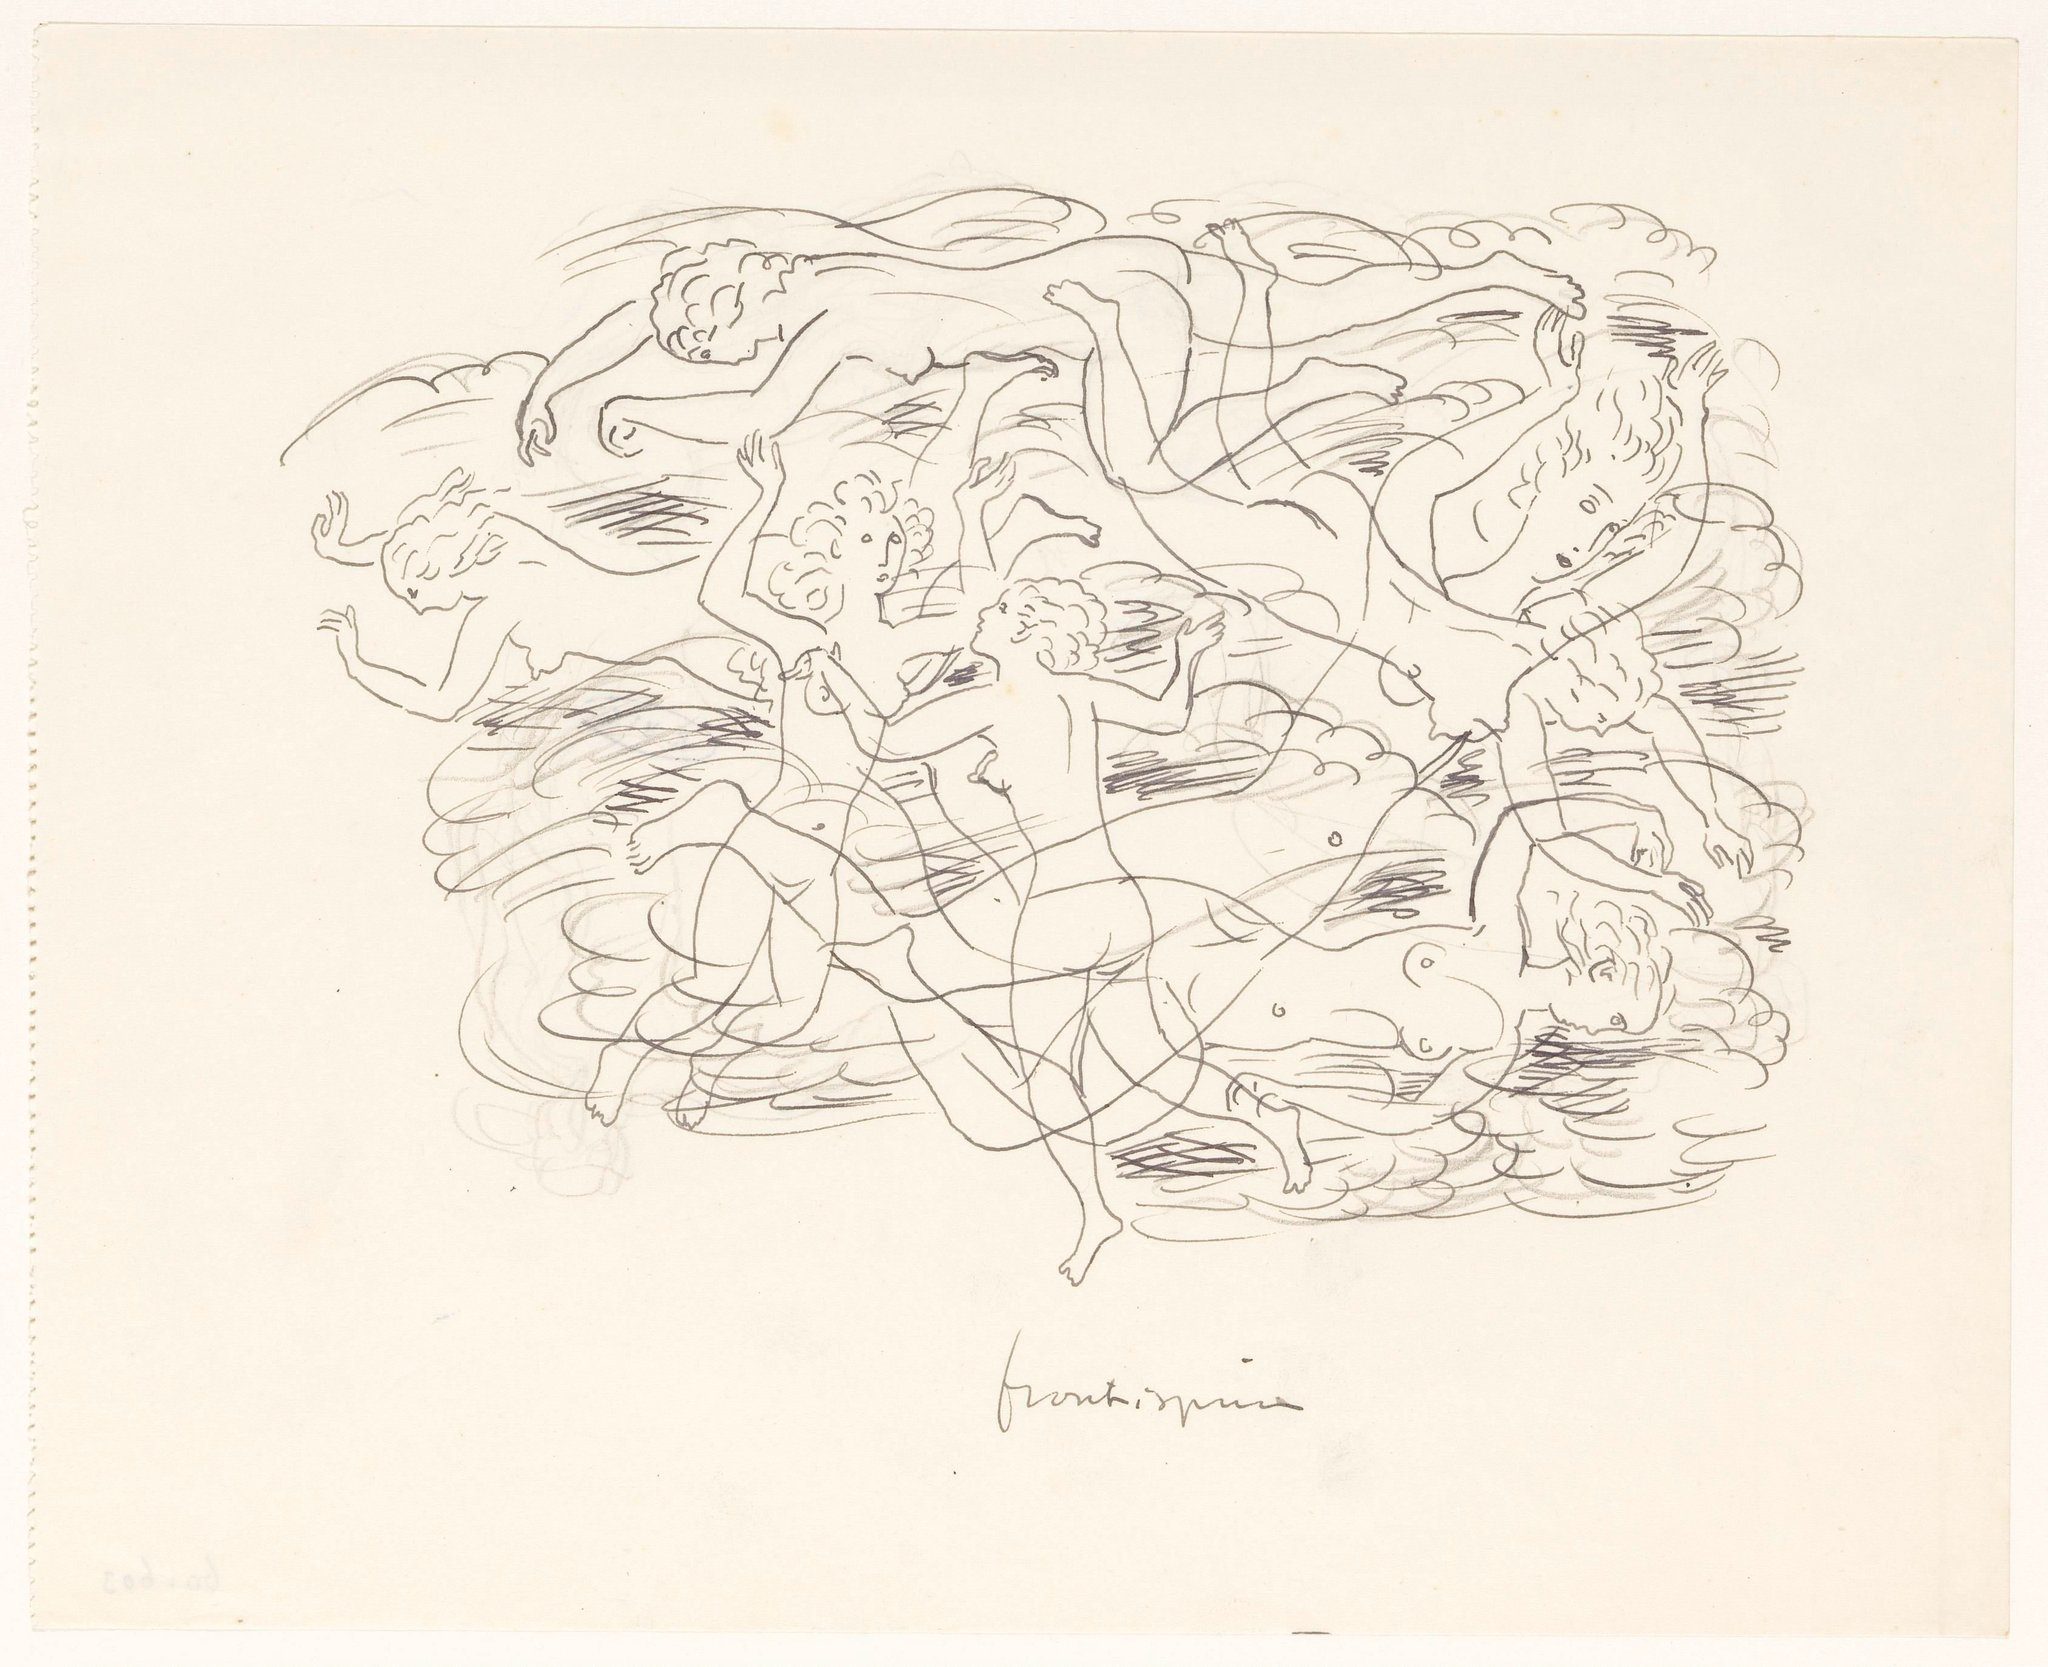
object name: drawing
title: Zwemmende naakte vrouwen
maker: leo gestel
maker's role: draughtsman, print maker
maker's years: 1881-1941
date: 1891-1941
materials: ink, paper, pencil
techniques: pen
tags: swimming (movement in water) - aa - female human figure (+ nude human being)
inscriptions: watermark: ‘GW/ PAPIER/ 1671’, :, collector's mark: Lugt 2228